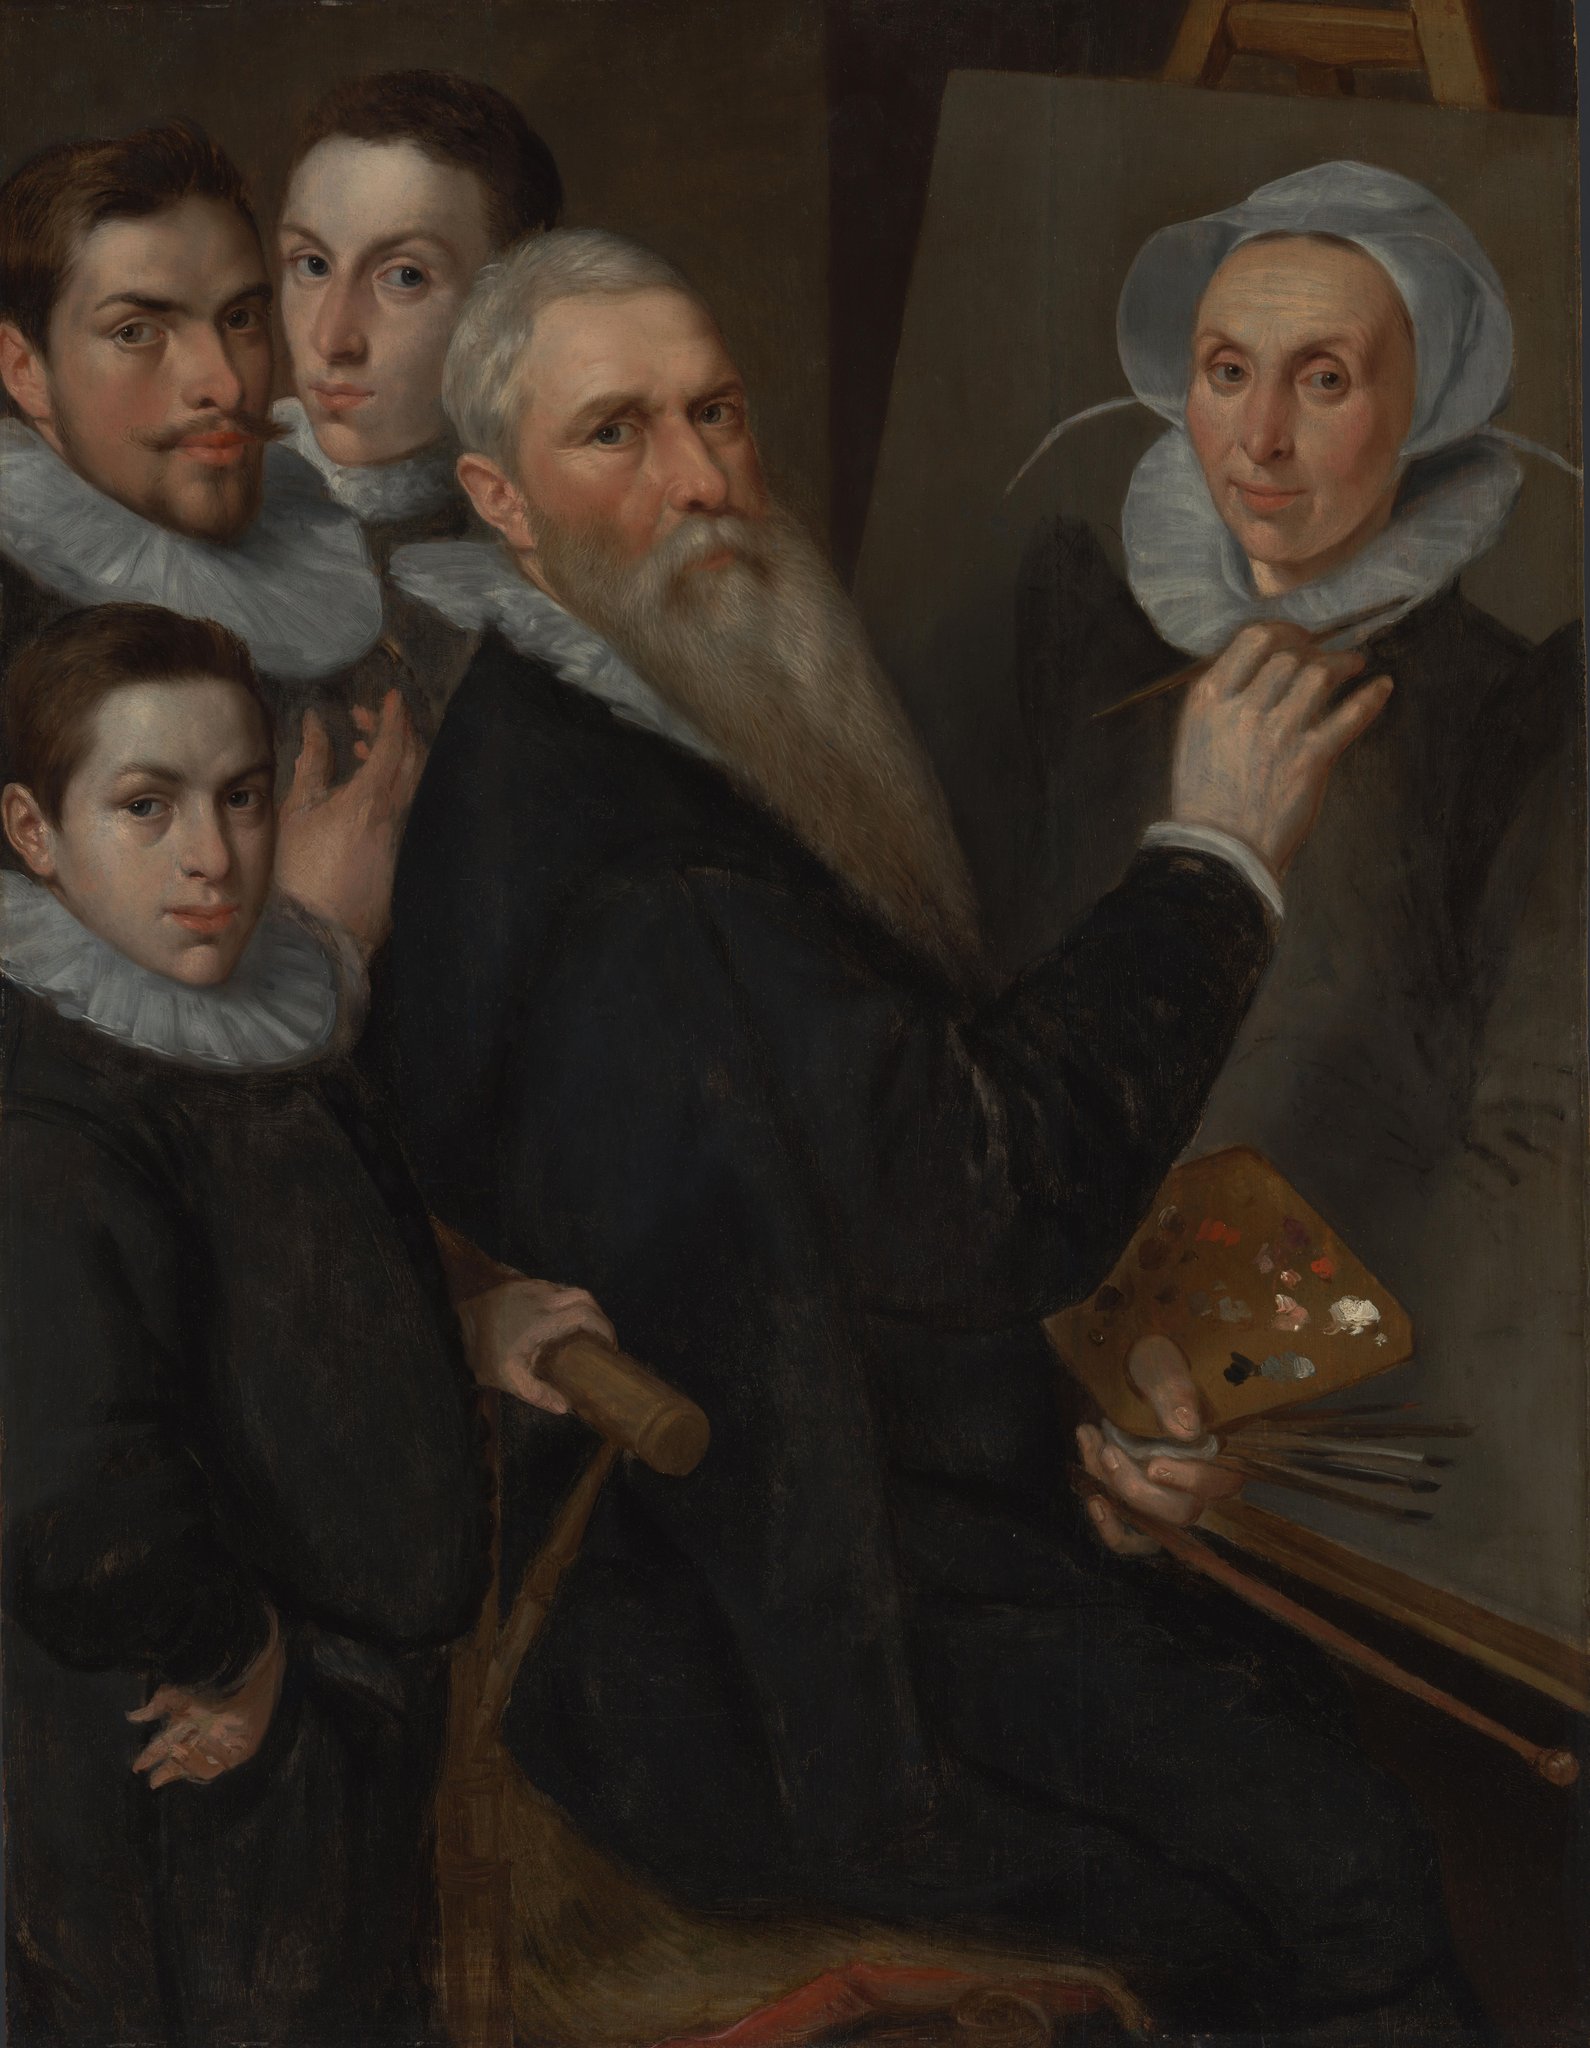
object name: painting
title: Self-portrait of the Painter with his Family, Jacob Willemsz Delff i (ca. 1540/45-1601)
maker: jacob willemsz. delff (i)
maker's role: painter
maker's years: 1540-1601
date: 1594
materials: oil, panel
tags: willem jacobsz delff, jacob willemsz. delff (i), gouda, delft, painter, cornelis jacobsz. delff, rochus delff, historical persons - bb - woman, family group, especially parents with their child(ren), historical persons, portrait, self-portrait of painter, portrait, self-portrait of artist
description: In his self-portrait, Jacob Willemsz Delff i is painting a portrait of his wife Maria Joachimsdr Nagel, with their three sons standing behind him. At the upper left are Cornelis and Rochus Delff, who both became painters and were probably already assistants in their father’s studio at the time of this self-portrait. Willem, in the left foreground, later became an engraver. The artistic family peers out at us with a penetrating gaze.